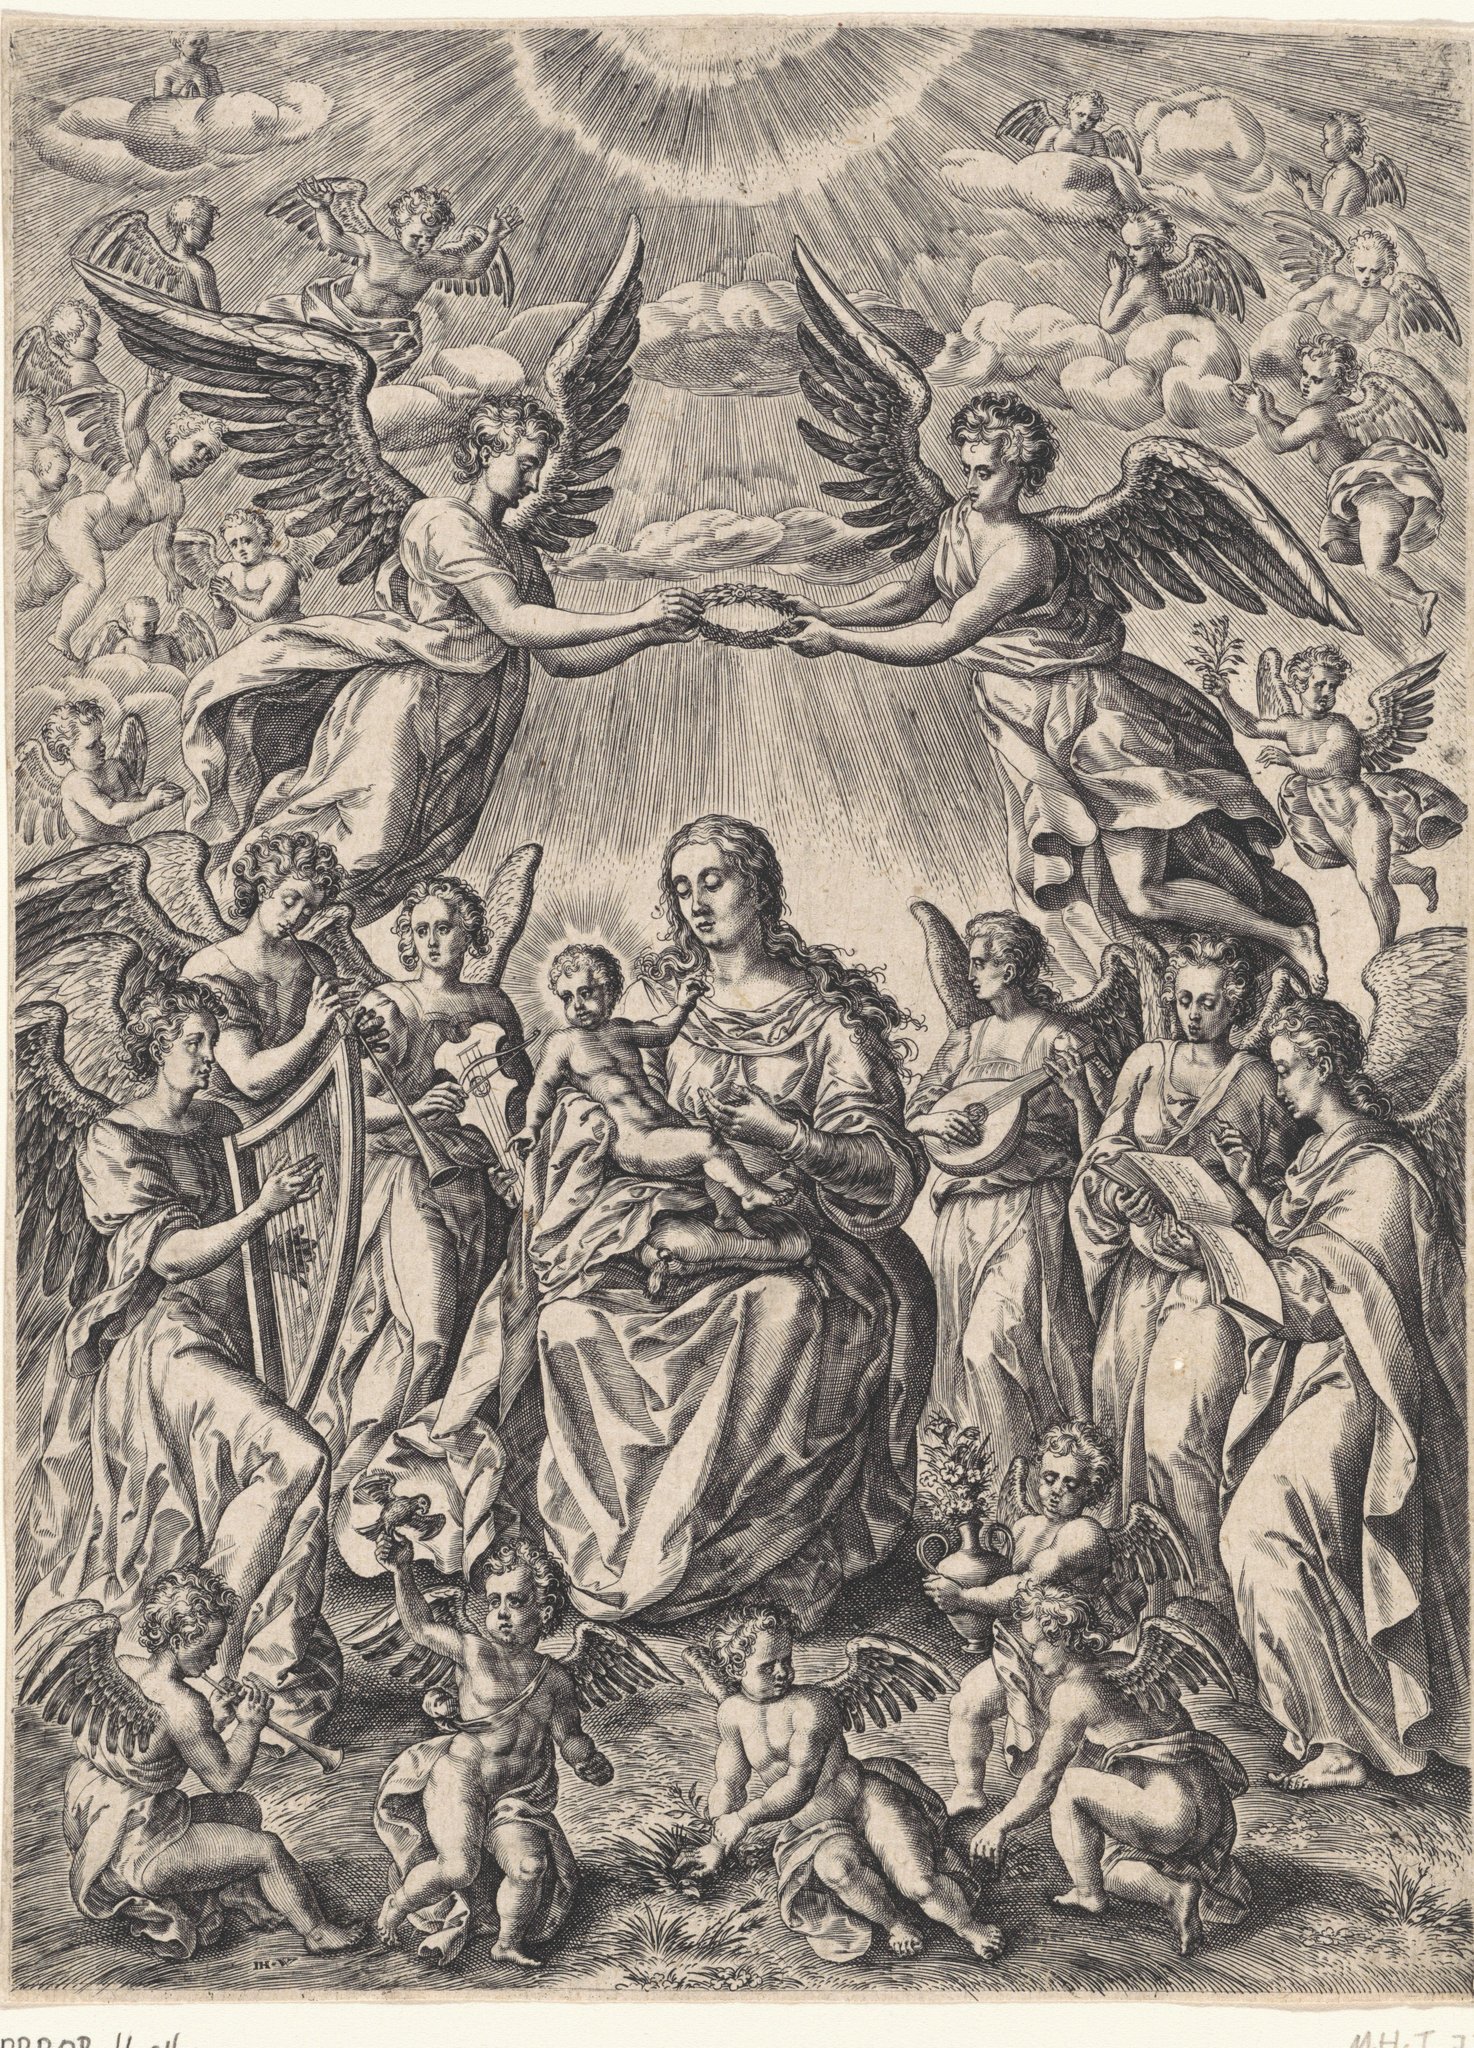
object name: print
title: Maria met het Christuskind, omringd door een menigte engelen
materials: paper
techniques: engraving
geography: antwerp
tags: musical instruments; group of musical instruments, madonna: mary sitting on the ground, the christ-child in her lap (+ angels floating in the air), crowning with laurel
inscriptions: collector's mark: Lugt 240, number: ‘22. - 60.’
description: Maria zit met het Christuskind op schoot op het gras. Ze wordt gelauwerd door twee engelen. Vanuit de lucht schijnen hemelse stralen op hen. Ze worden omringd door een menigte van musicerende engelen.